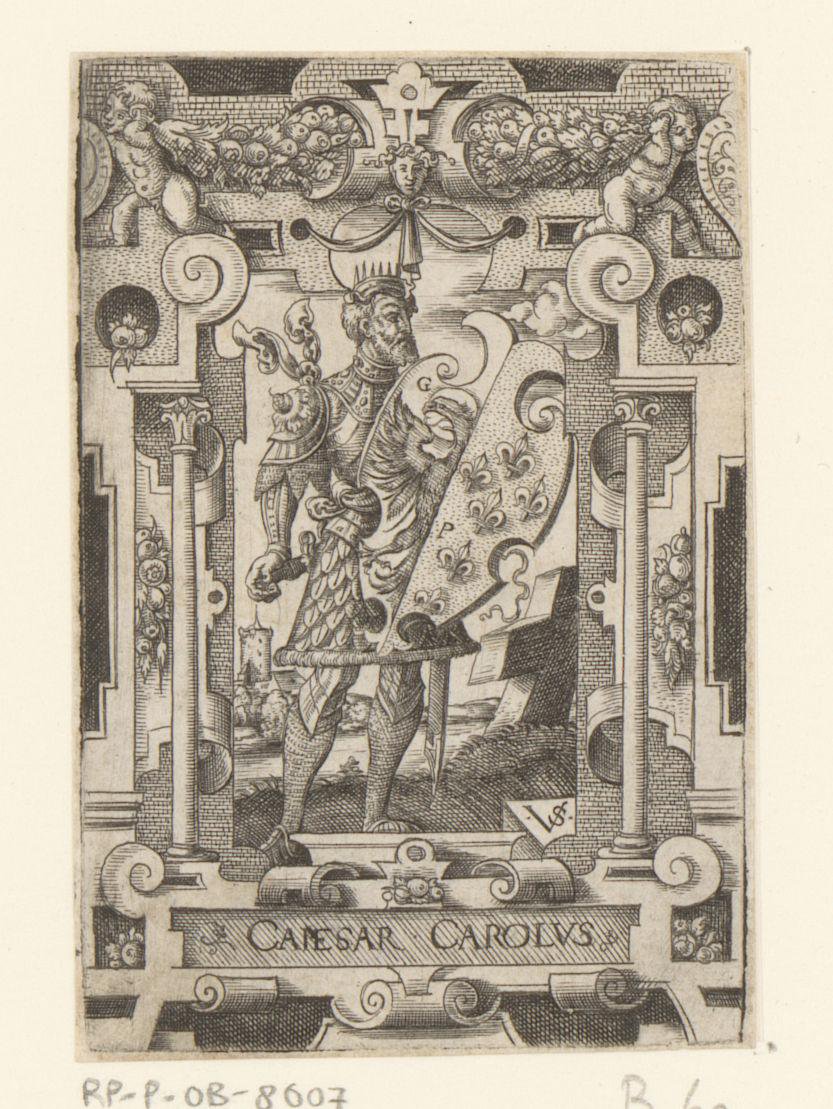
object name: print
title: Karel de Grote met wapenschild in rolwerk omlijsting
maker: virgilius solis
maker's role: draughtsman, print maker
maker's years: 1514-1562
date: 1524-1562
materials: paper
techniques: engraving, etching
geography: nuremberg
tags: charlemagne (holy roman emperor), charlemagne (one of the nine worthies)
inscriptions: collector's mark: Lugt 2228, number: ‘124’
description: Deze prent maakt deel uit van een serie bestaande uit negen prenten van de Negen Besten in rolwerk omlijstingen.